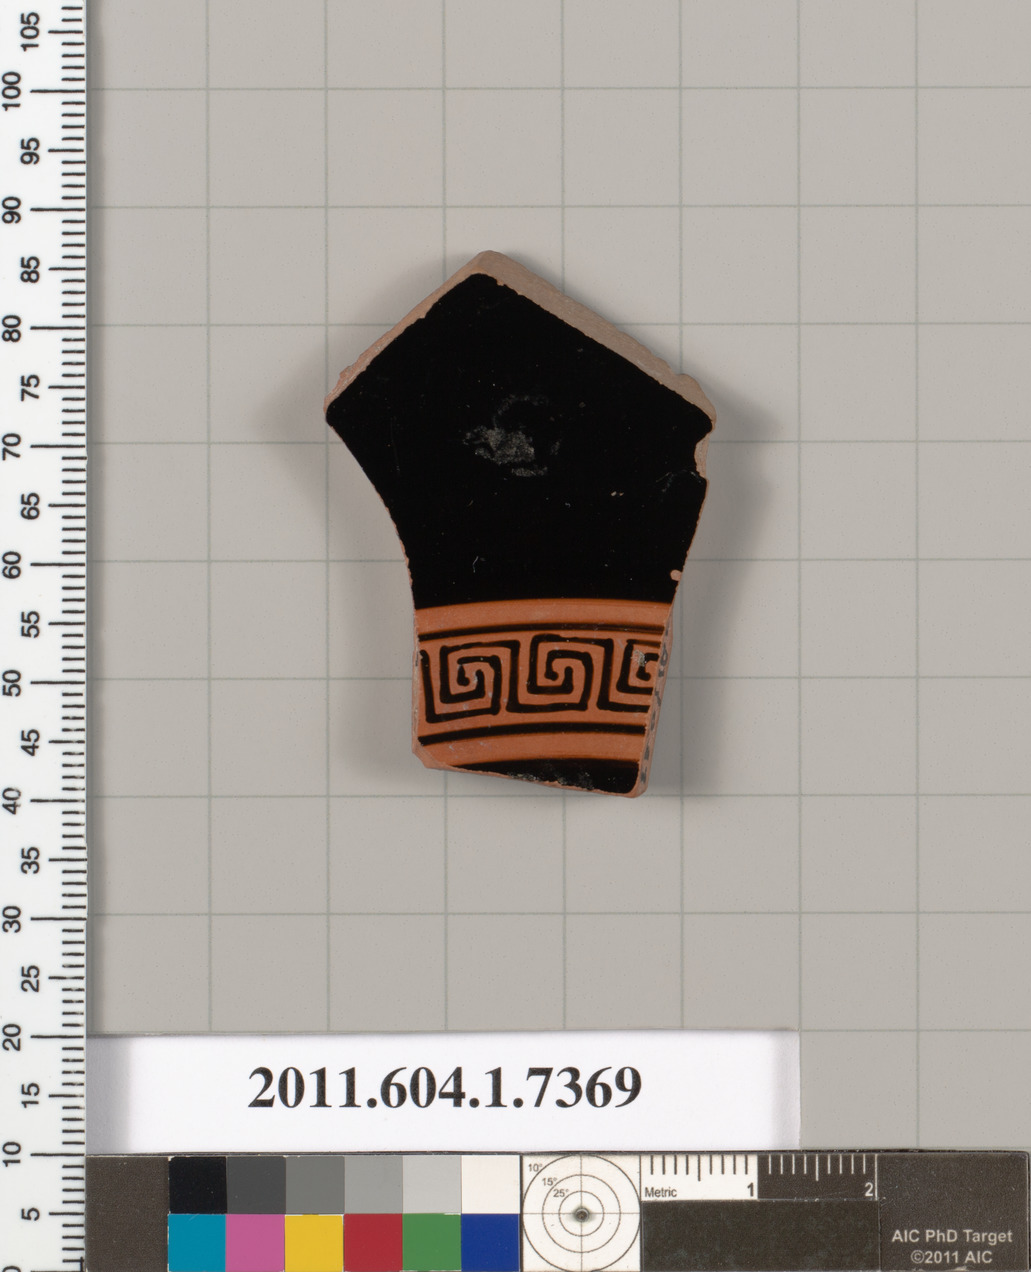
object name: kylix fragment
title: Terracotta fragment of a kylix (drinking cup)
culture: greek, attic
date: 500-480 BCE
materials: terracotta